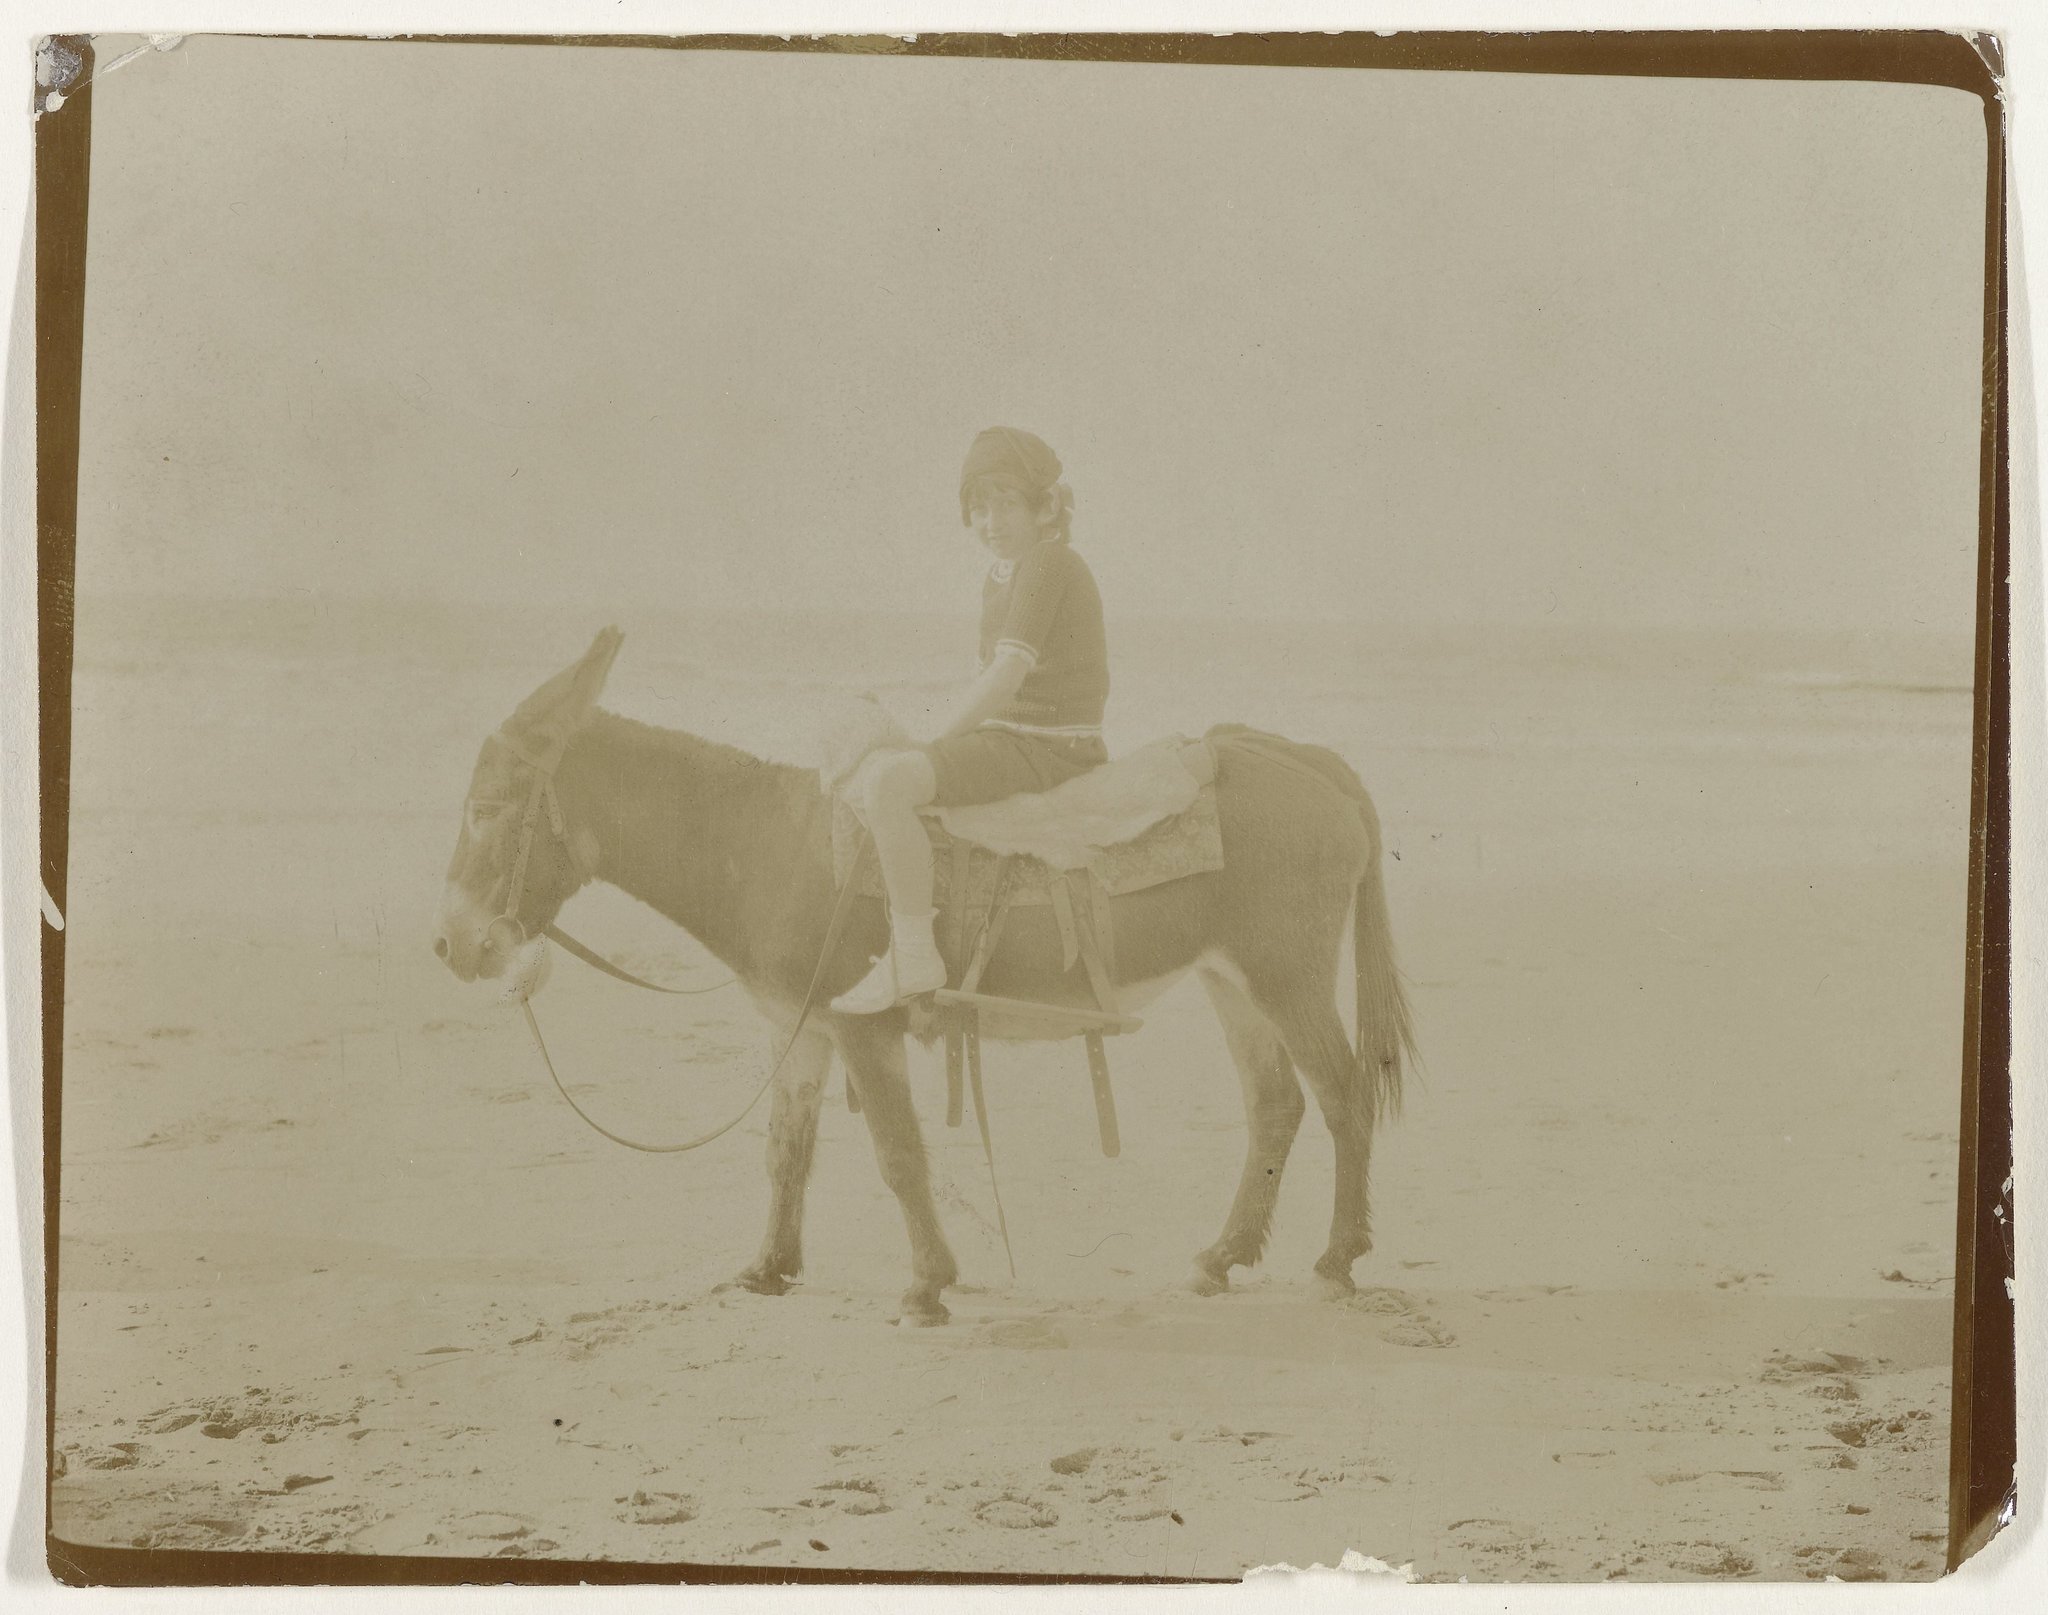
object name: photograph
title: Meisje op ezel aan het strand (Noordzeekust), Nederland of Duitsland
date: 1900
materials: paper, photographic support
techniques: gelatin silver print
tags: donkey-riding (on the beach), netherlands, germany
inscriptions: number: ‘B’